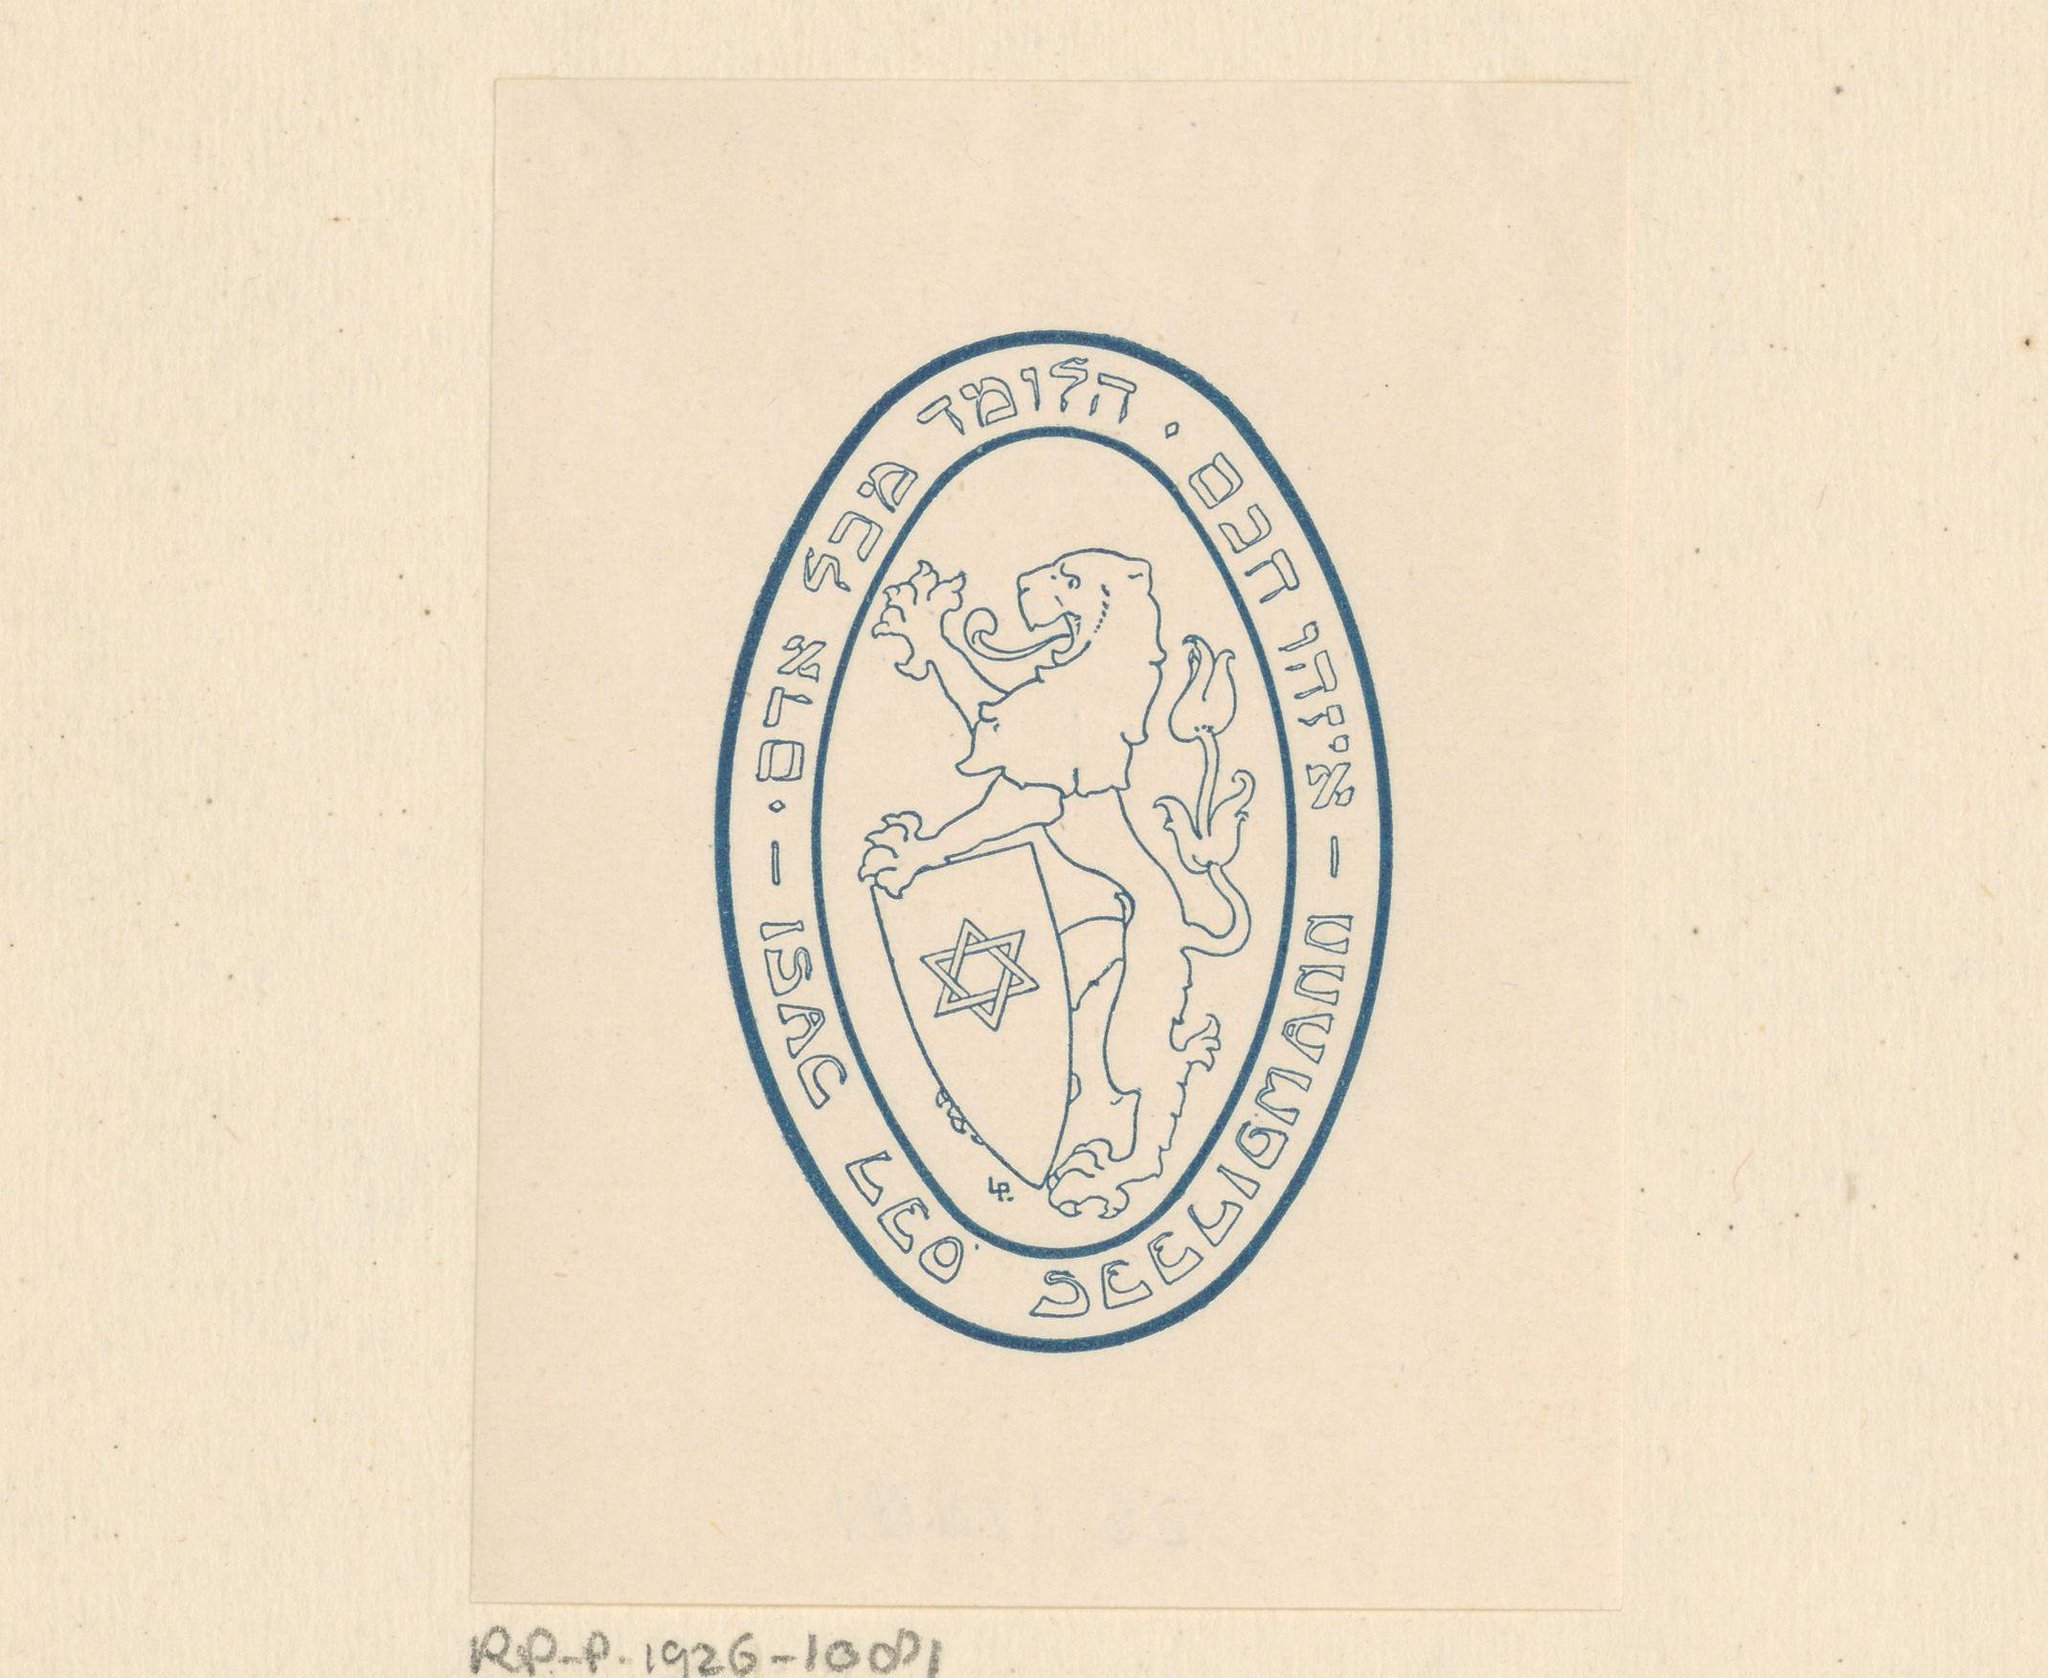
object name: bookplate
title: Ex libris van Isac Leo Seeligmann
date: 1917-1926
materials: paper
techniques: printing block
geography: netherlands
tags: amsterdam, beasts of prey, predatory animals: lion, armorial bearing, heraldry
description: Het motto luidt: "Wie is wijs? Die leert van ieder mensch".